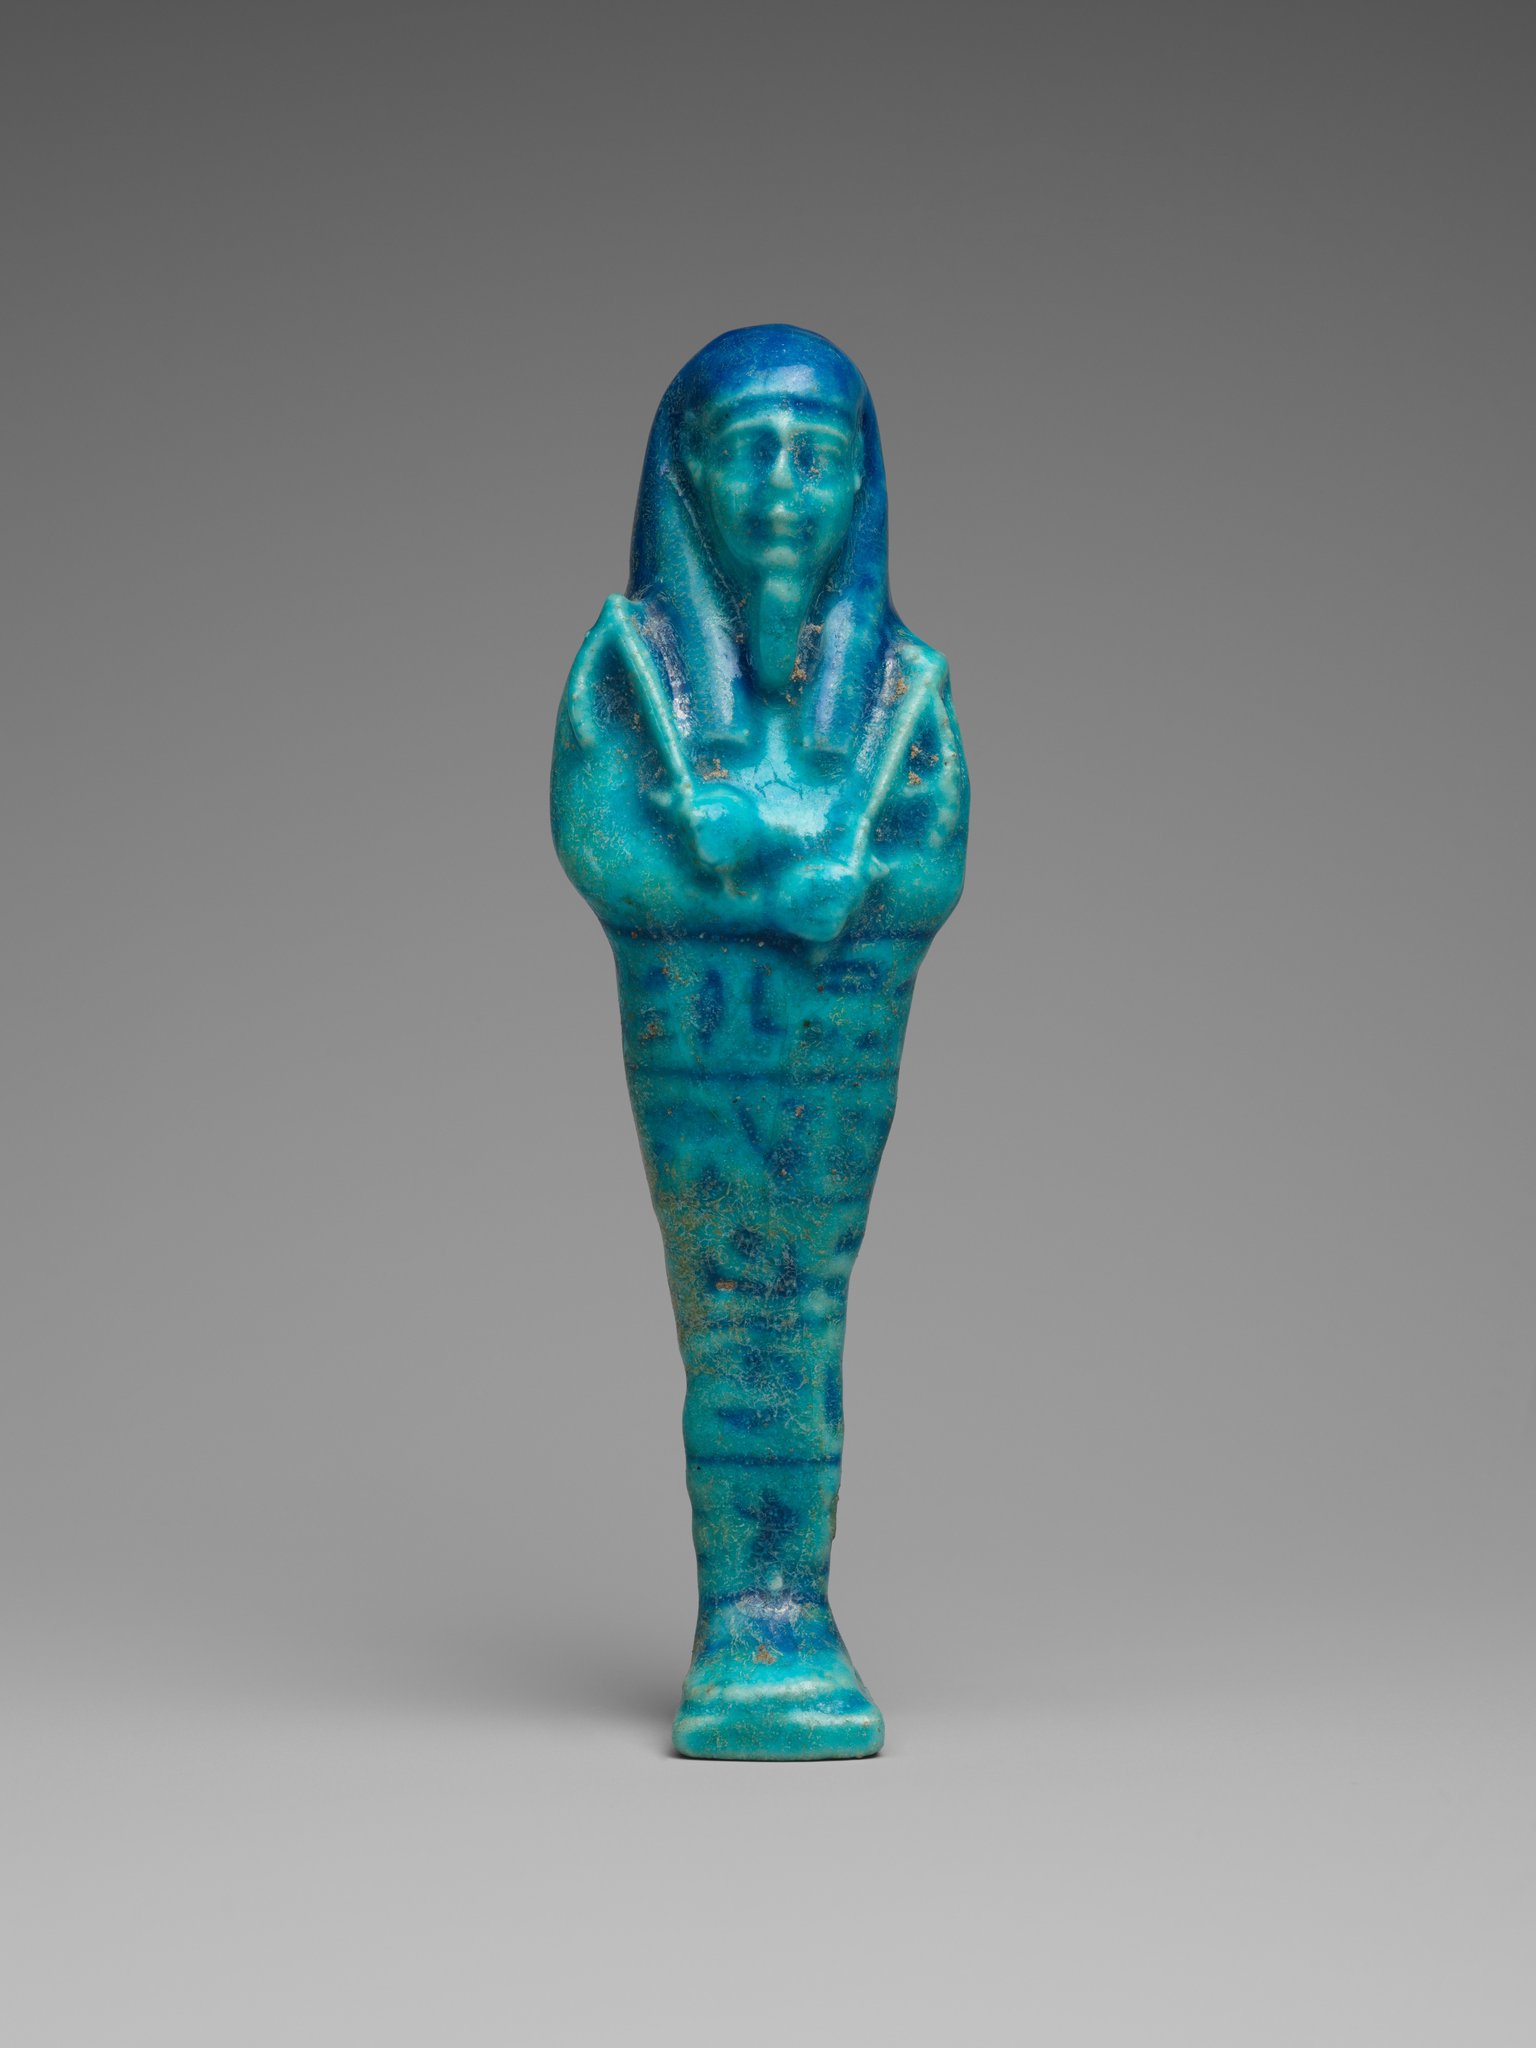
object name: shabti, petosiris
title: Shabti of Petosiris, son of Djedhor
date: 360-300 BCE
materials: faience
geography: egypt